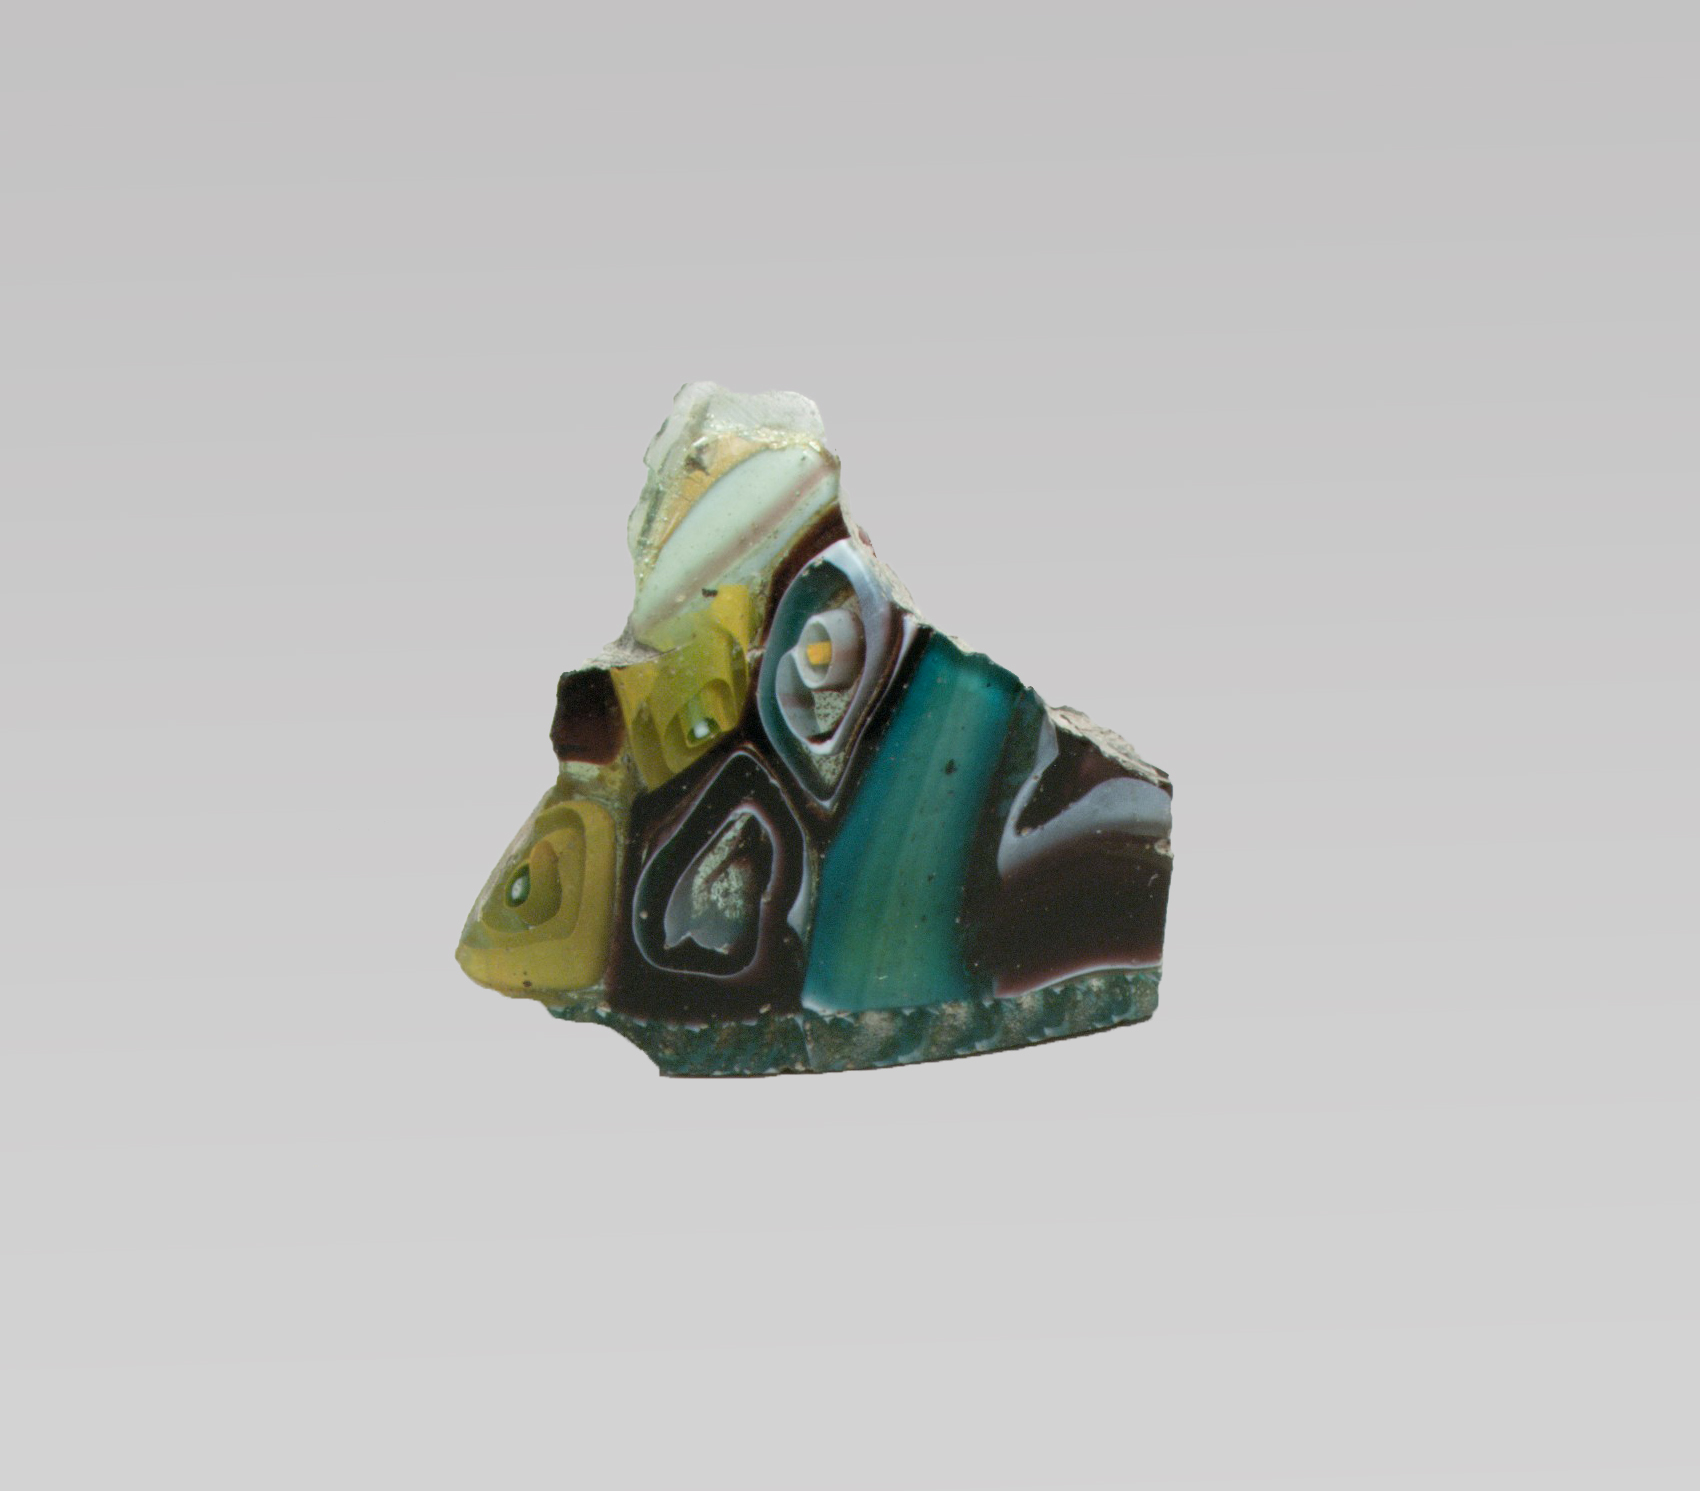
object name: fragment, mosaic bowl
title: Glass short-strip mosaic bowl fragment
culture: roman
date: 34 BCE-33 CE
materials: glass